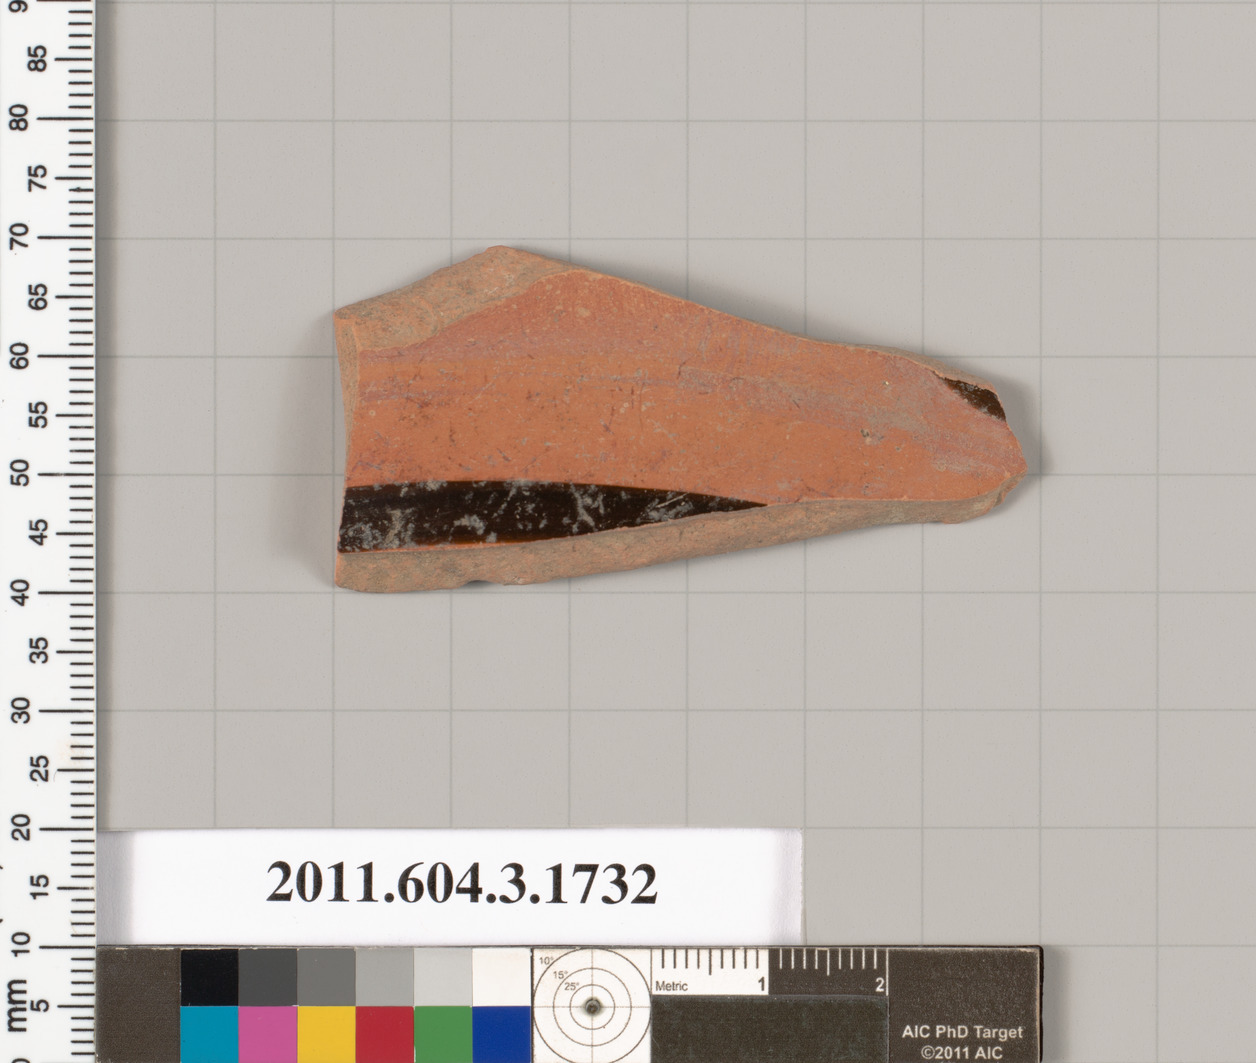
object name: kylix fragment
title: Terracotta fragment of a kylix: Band or lip cup (drinking cup)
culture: greek, attic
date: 550-526 BCE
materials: terracotta